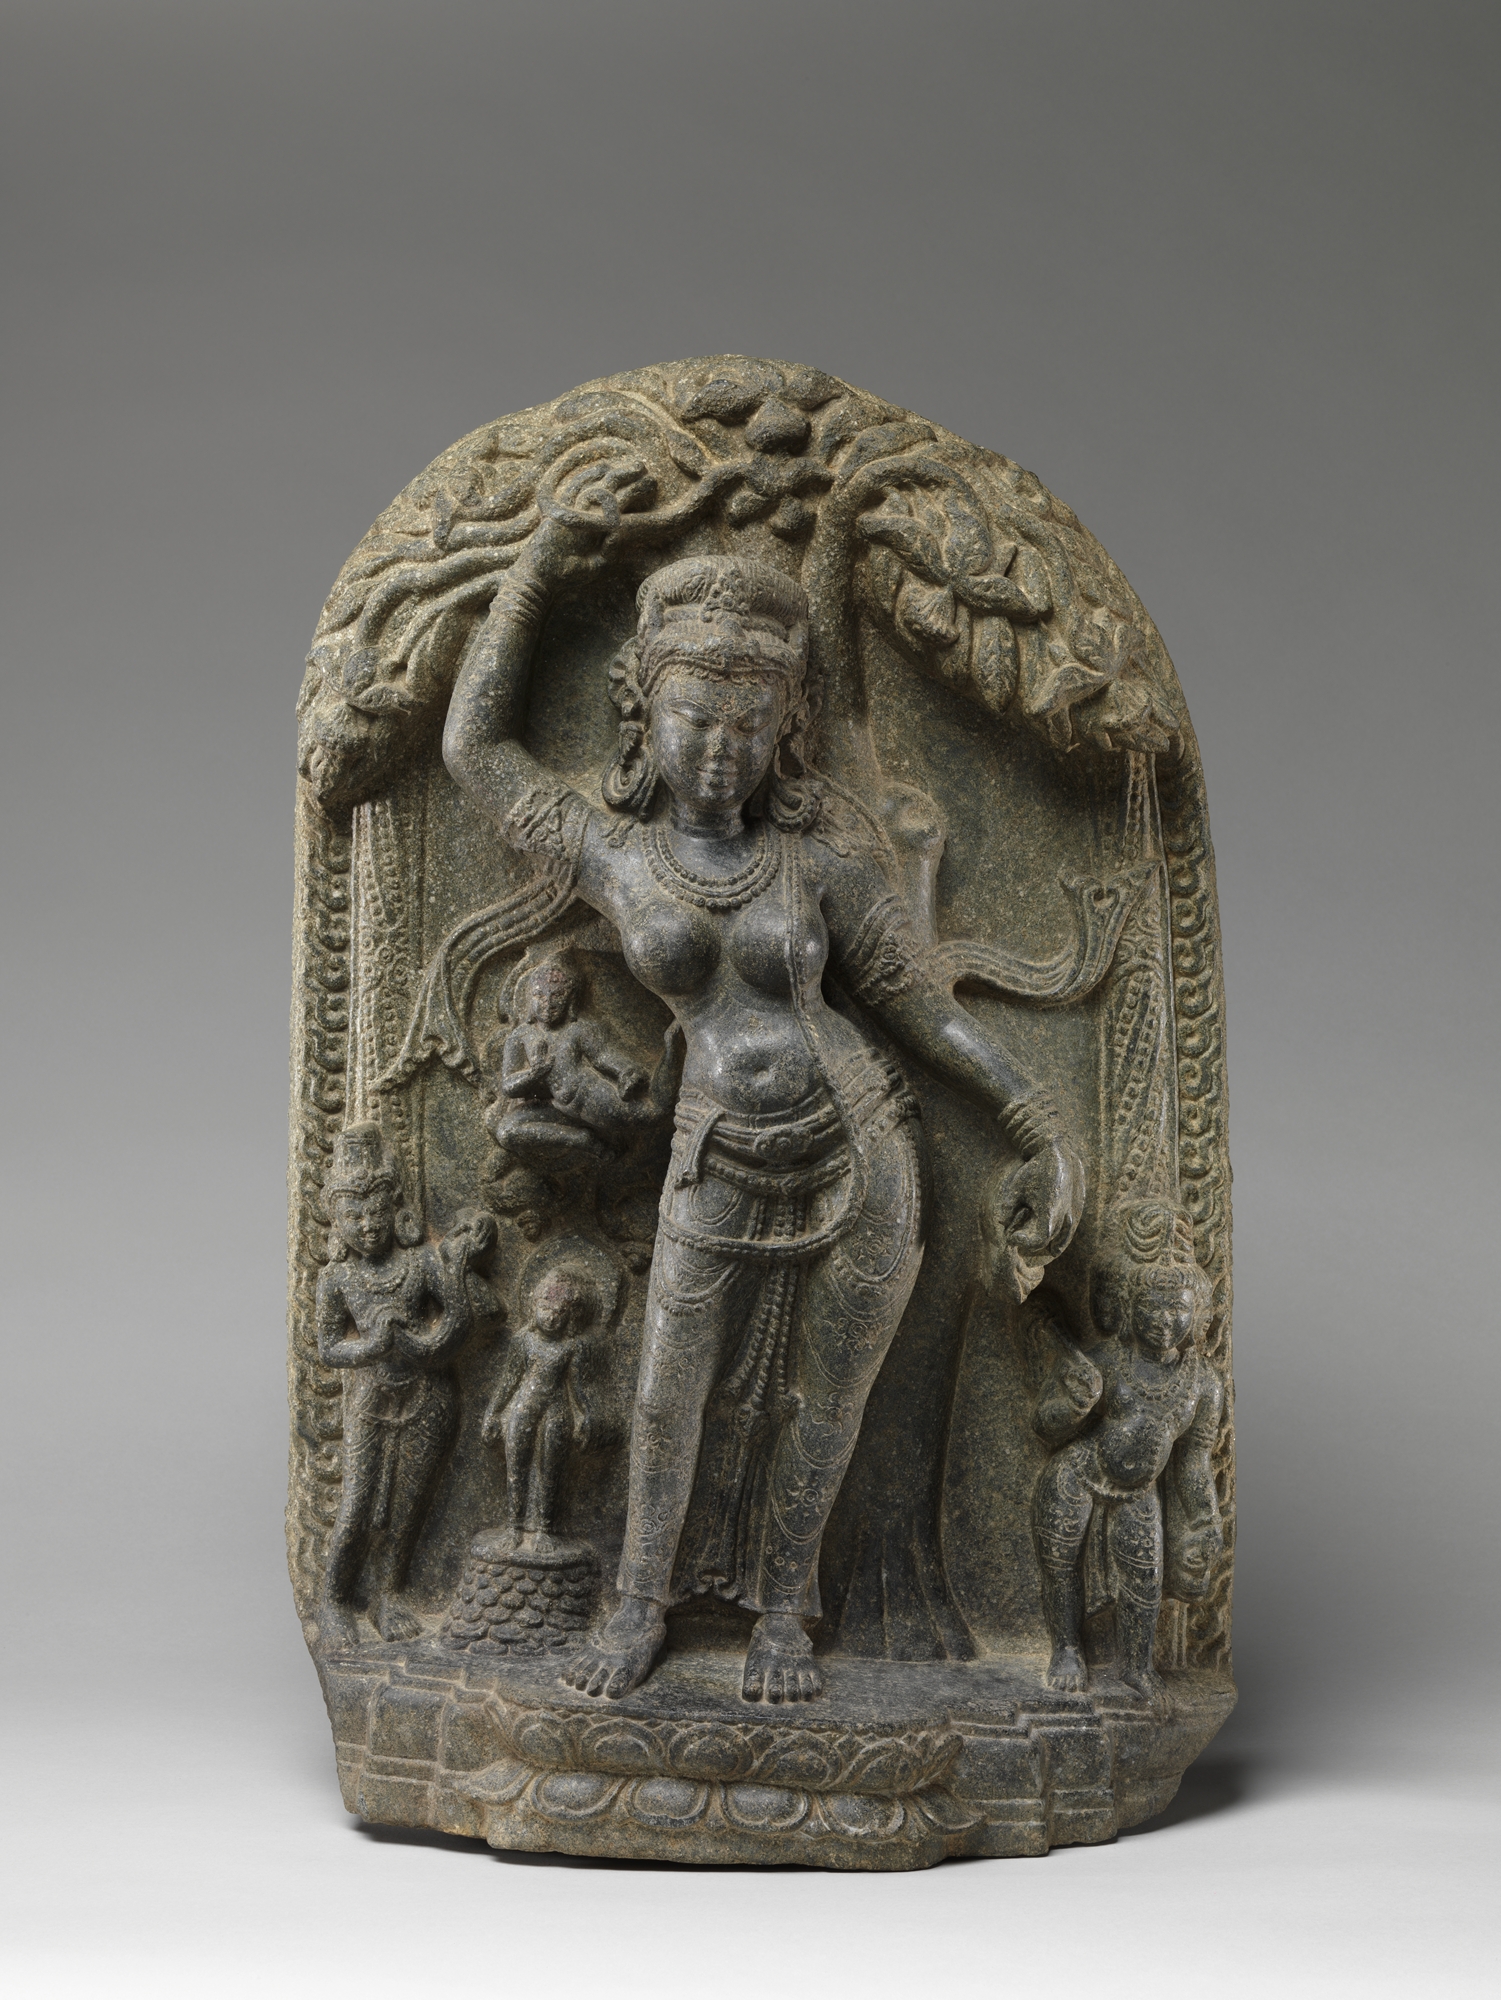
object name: stele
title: Birth of the Buddha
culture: indian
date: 1001-1100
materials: stone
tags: buddhism,buddha